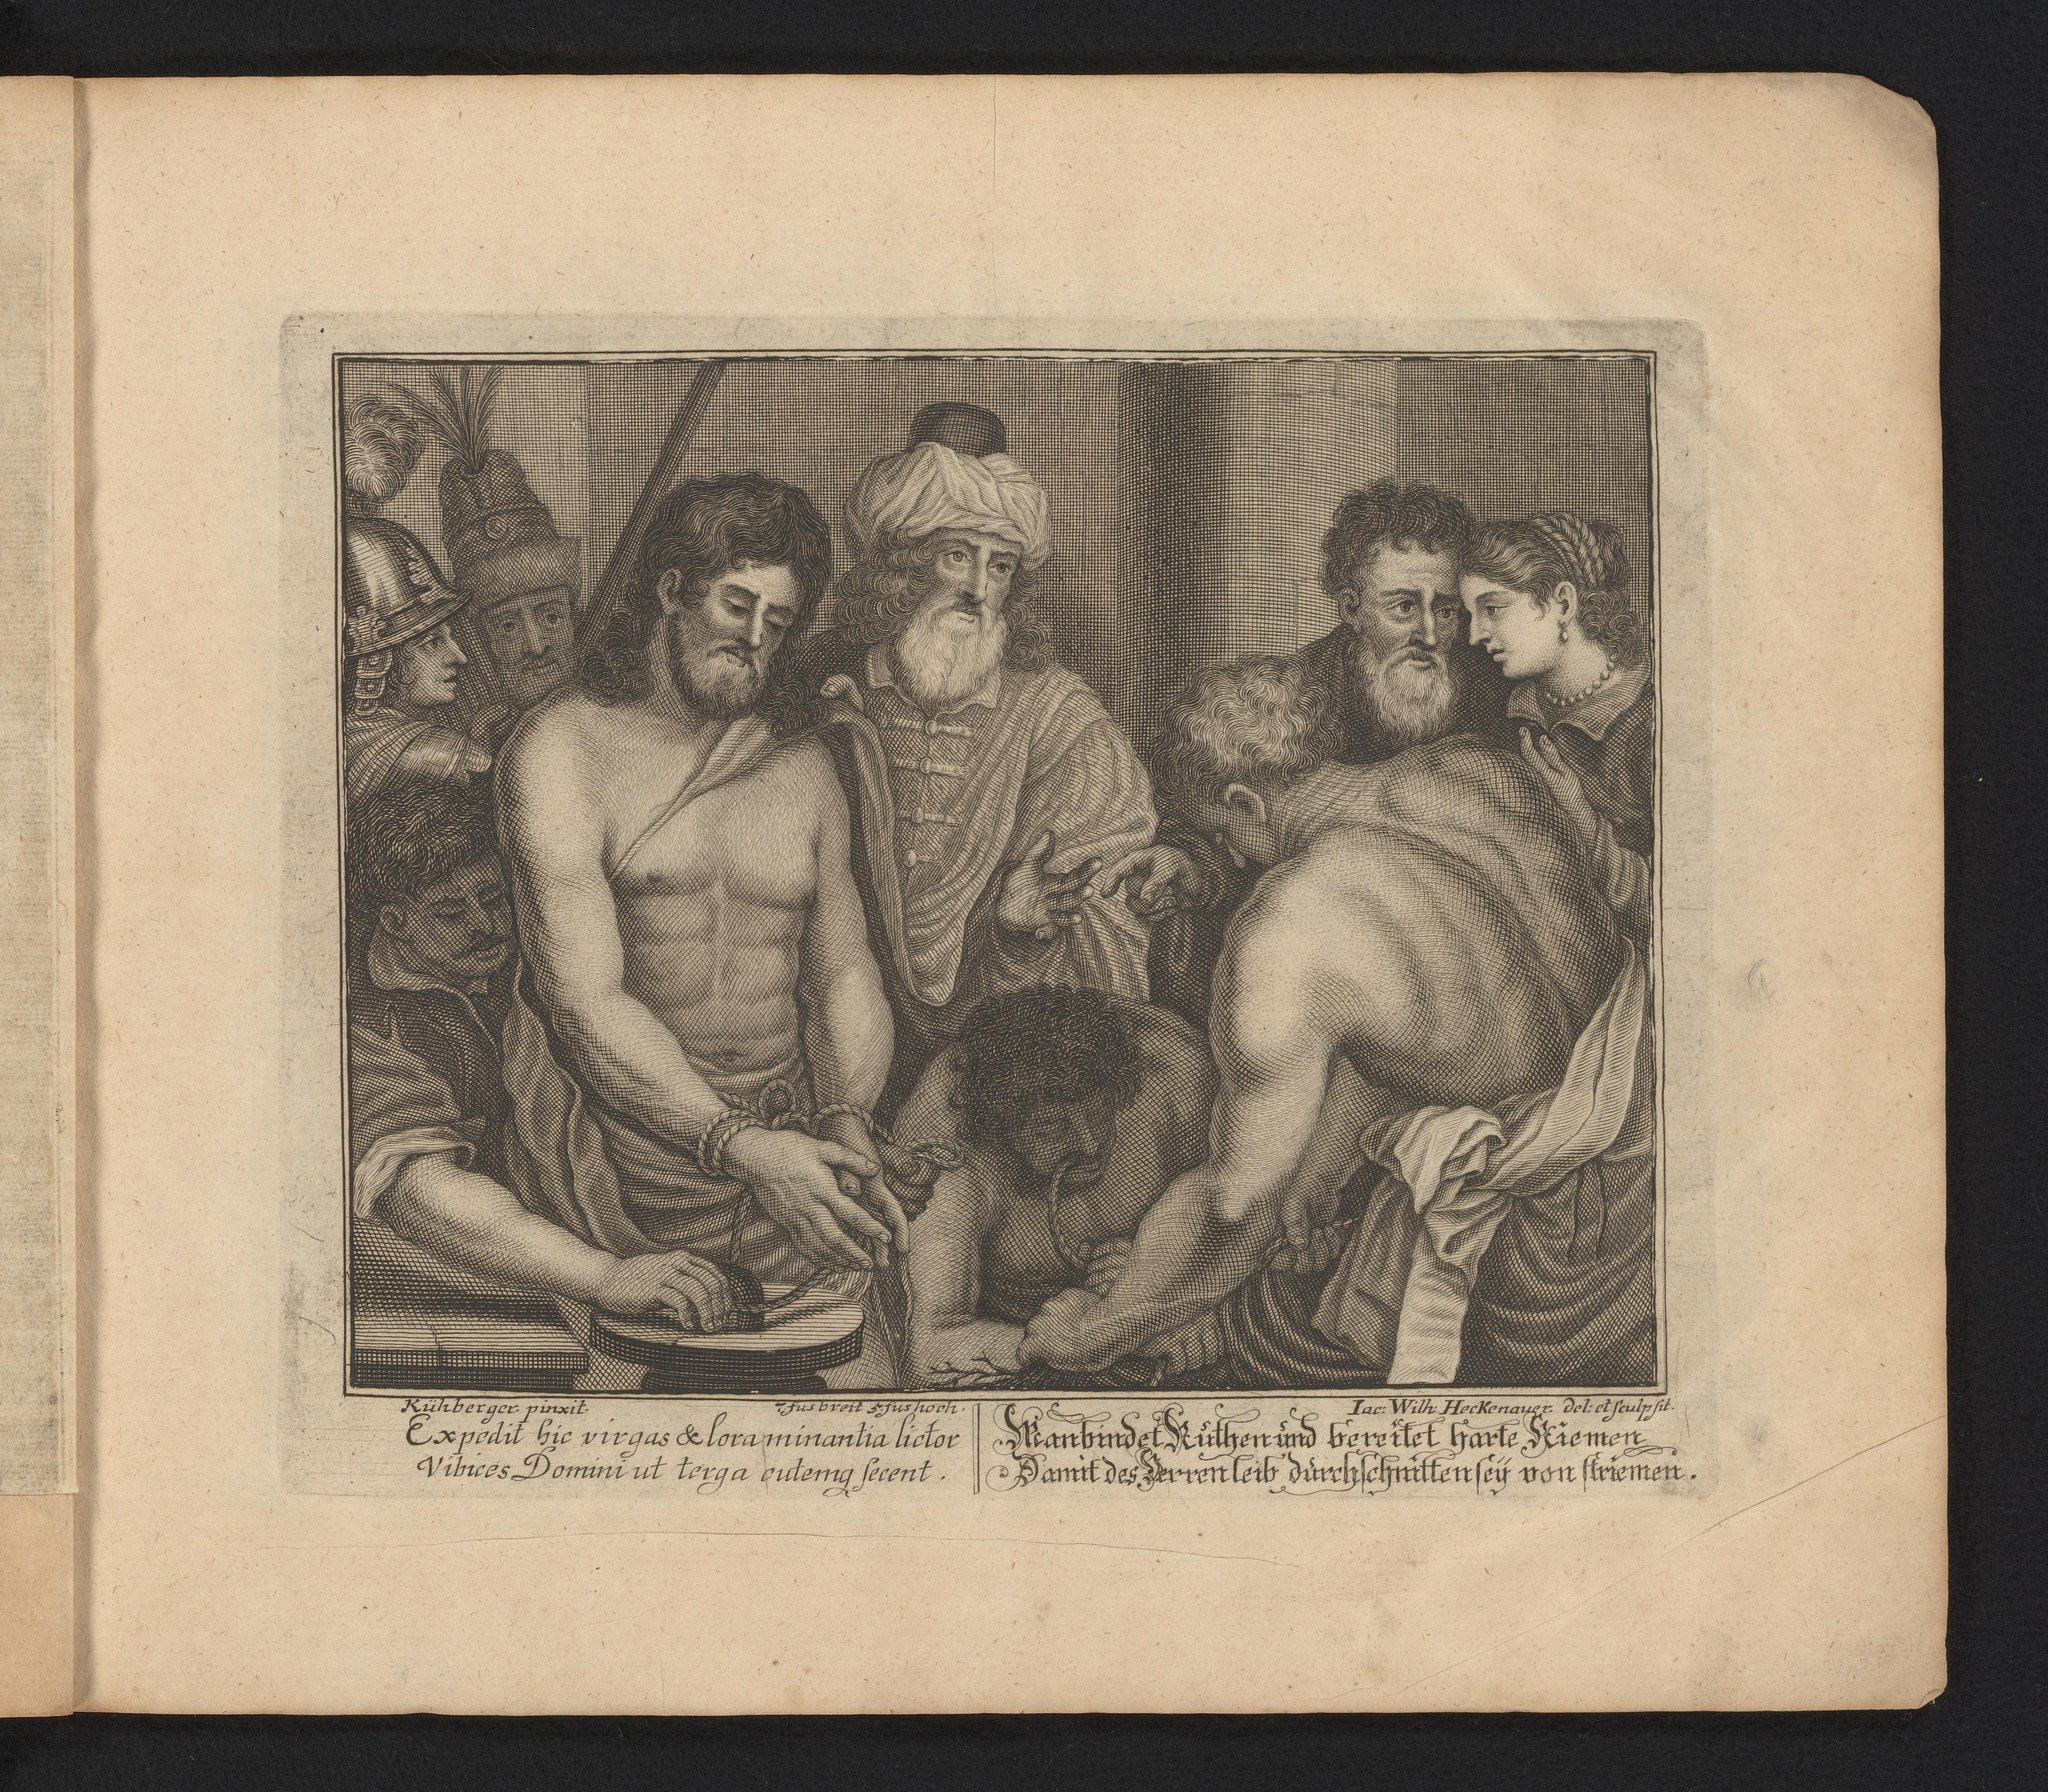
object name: album leaf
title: Ecce Homo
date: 1710-1714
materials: paper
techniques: engraving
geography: wolfenbüttel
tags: pilate showing christ to the people, 'ostentatio christi', 'ecce homo' (john 19:4-6)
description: Tekst in het Duits en het Latijn in de ondermarge. Prent maakt deel uit van een album.